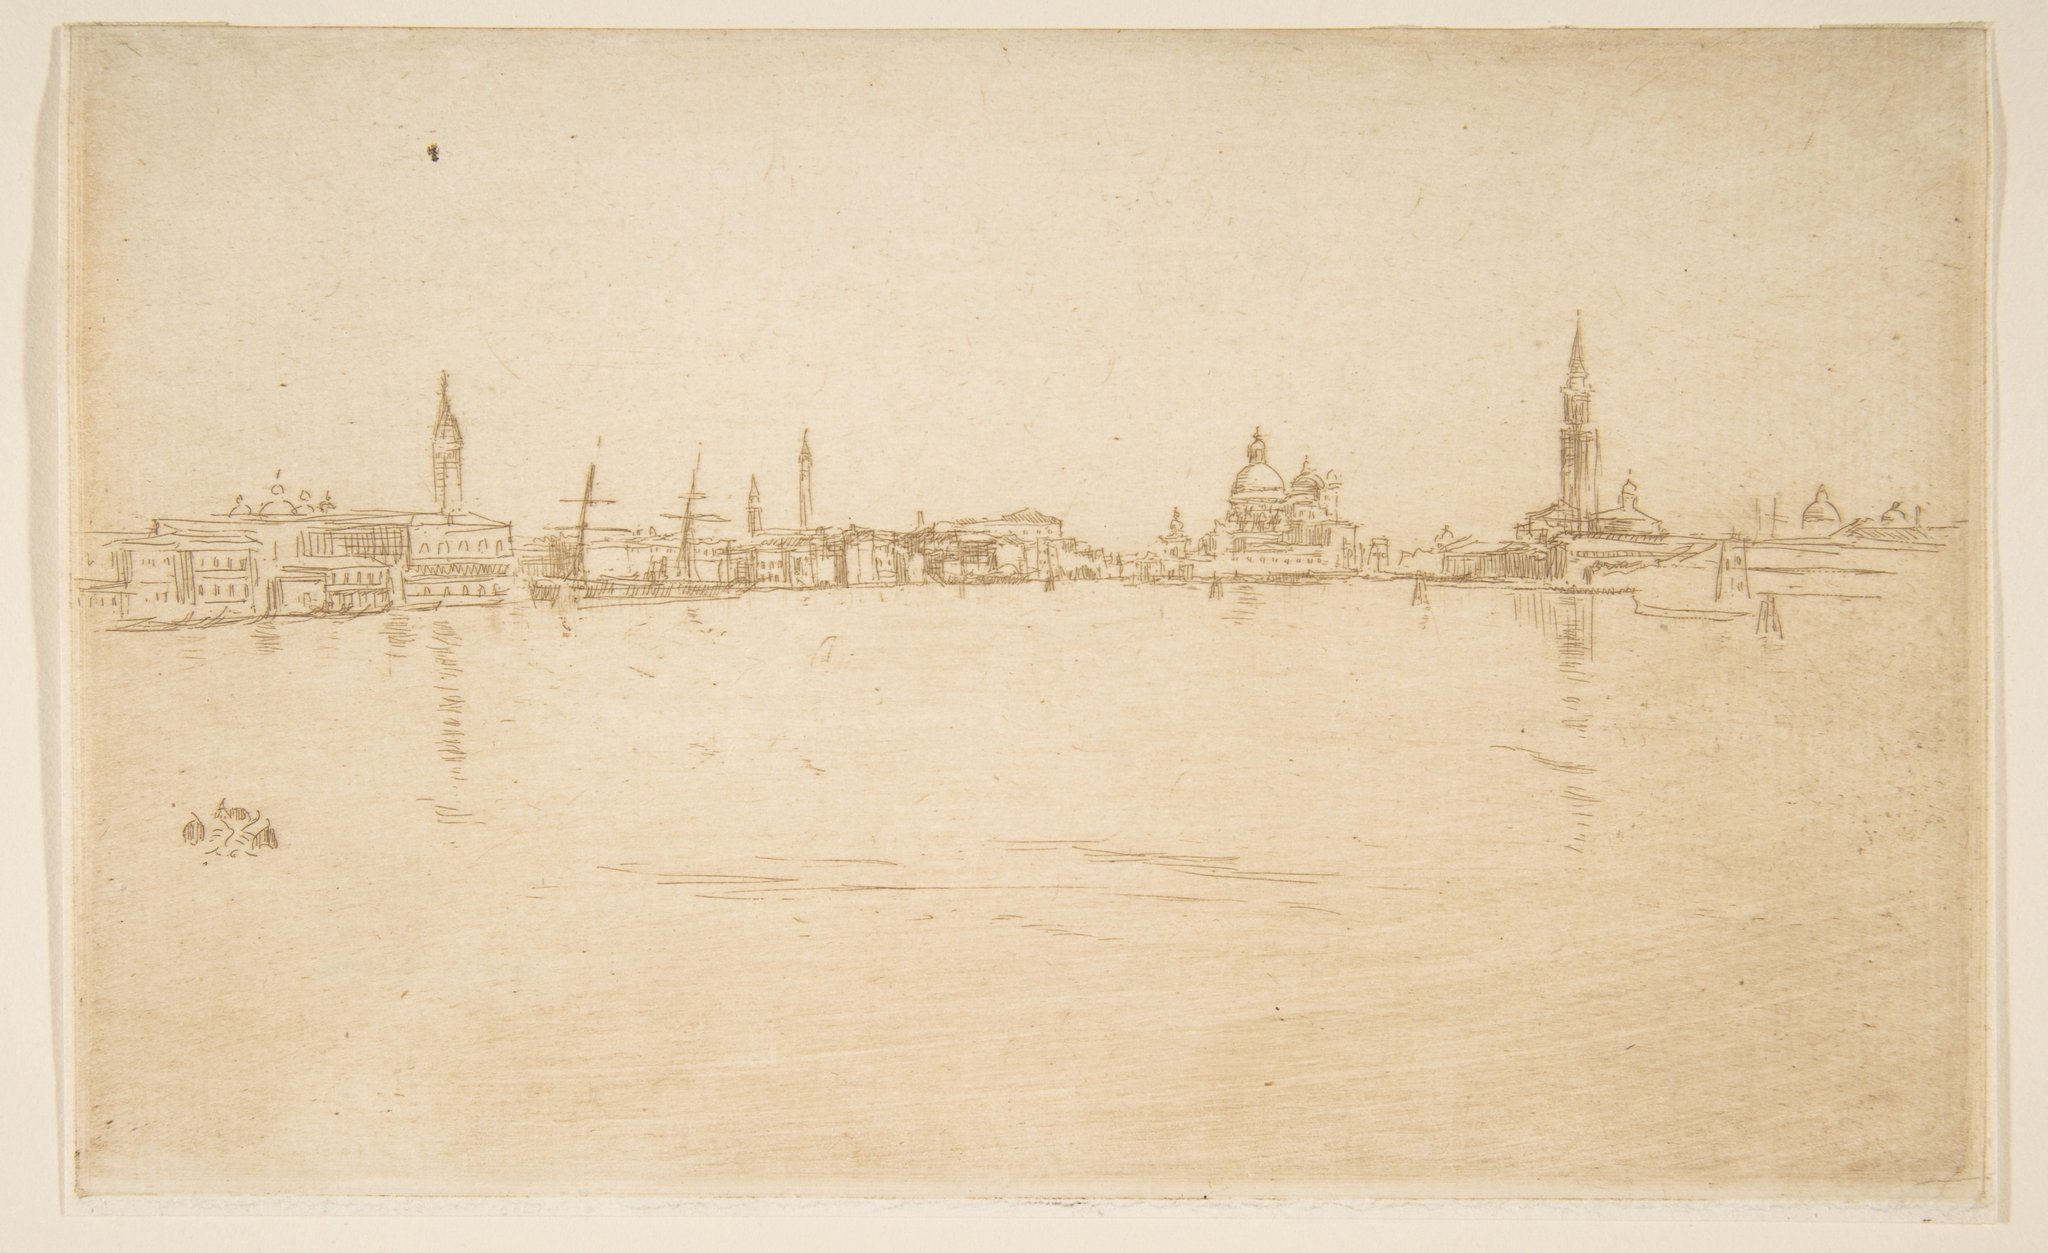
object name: print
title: La Salute: Dawn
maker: james mcneill whistler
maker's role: artist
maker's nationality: american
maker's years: 1834-1903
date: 1879-1880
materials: ink, paper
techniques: drypoint, etching, printing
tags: buildings,boats,venice